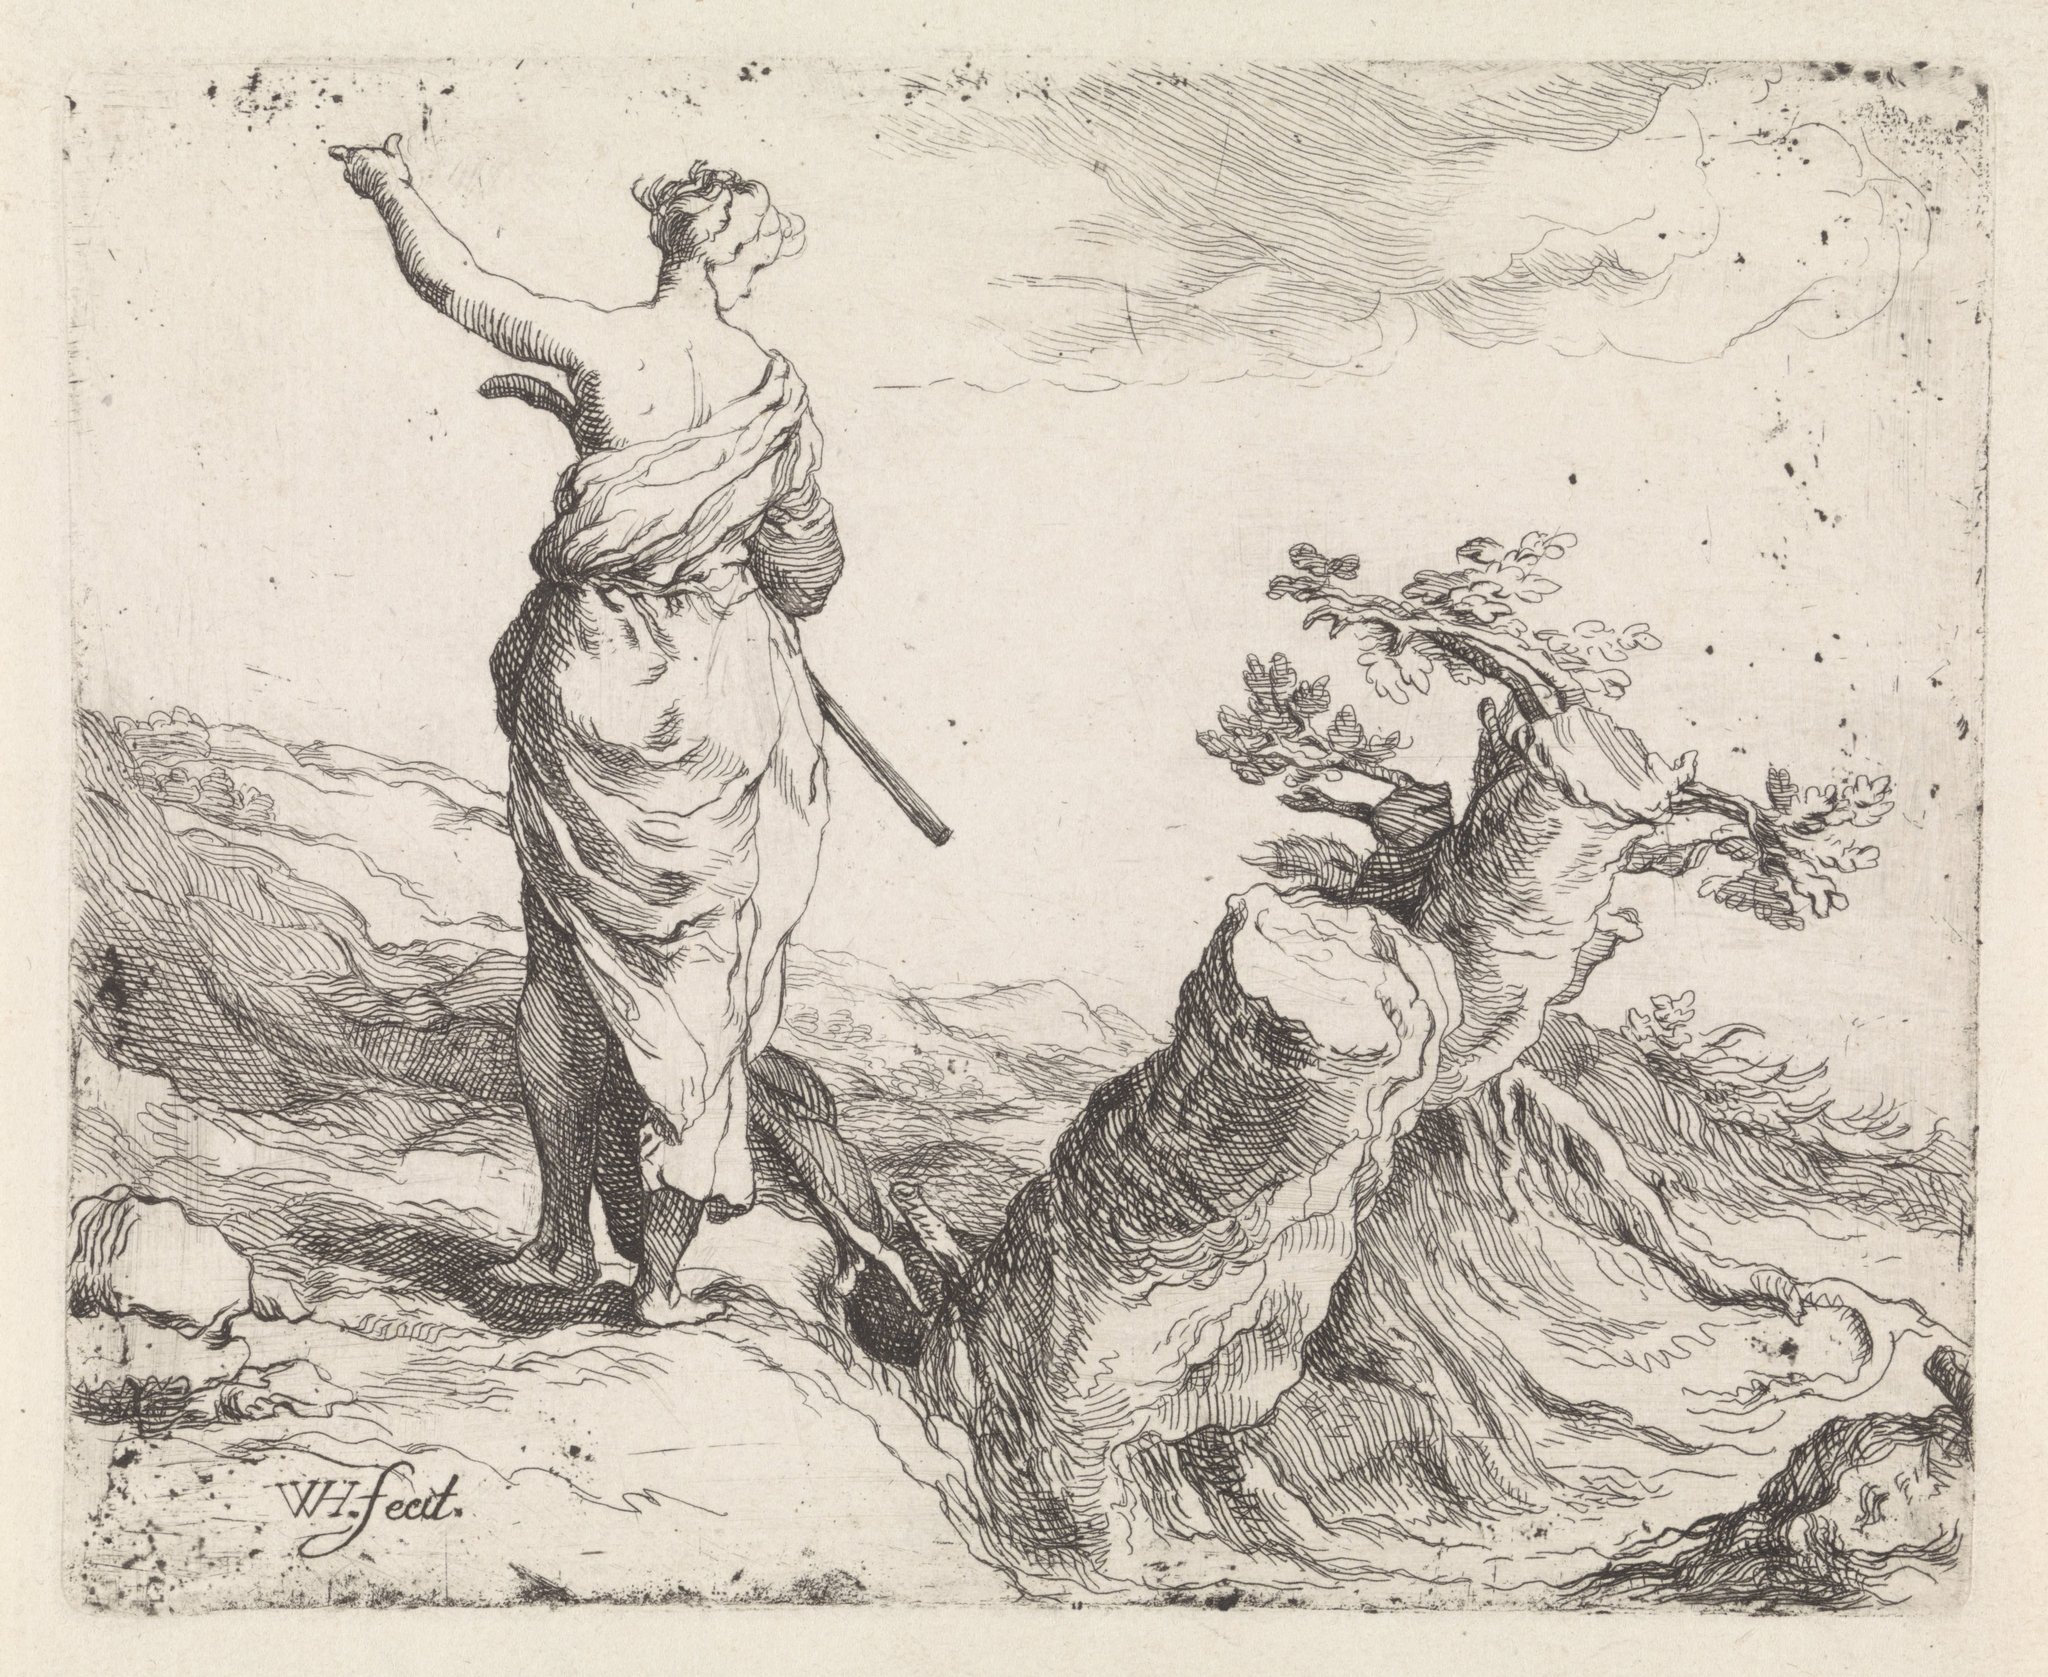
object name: print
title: Landschap met vrouw bij een boomstronk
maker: warner horstink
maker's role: draughtsman, print maker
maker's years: 1756-1815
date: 1766-1815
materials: paper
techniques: etching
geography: haarlem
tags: walking-stick, staff, arm raised upward (+ back view), trees (+ stump, stub)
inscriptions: collector's mark: Lugt 240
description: Landschap met een vrouw, op de rug gezien met in haar hand een herdersstaf, bij een boomstronk. Met haar linkerarm wijst zij naar in de verte.